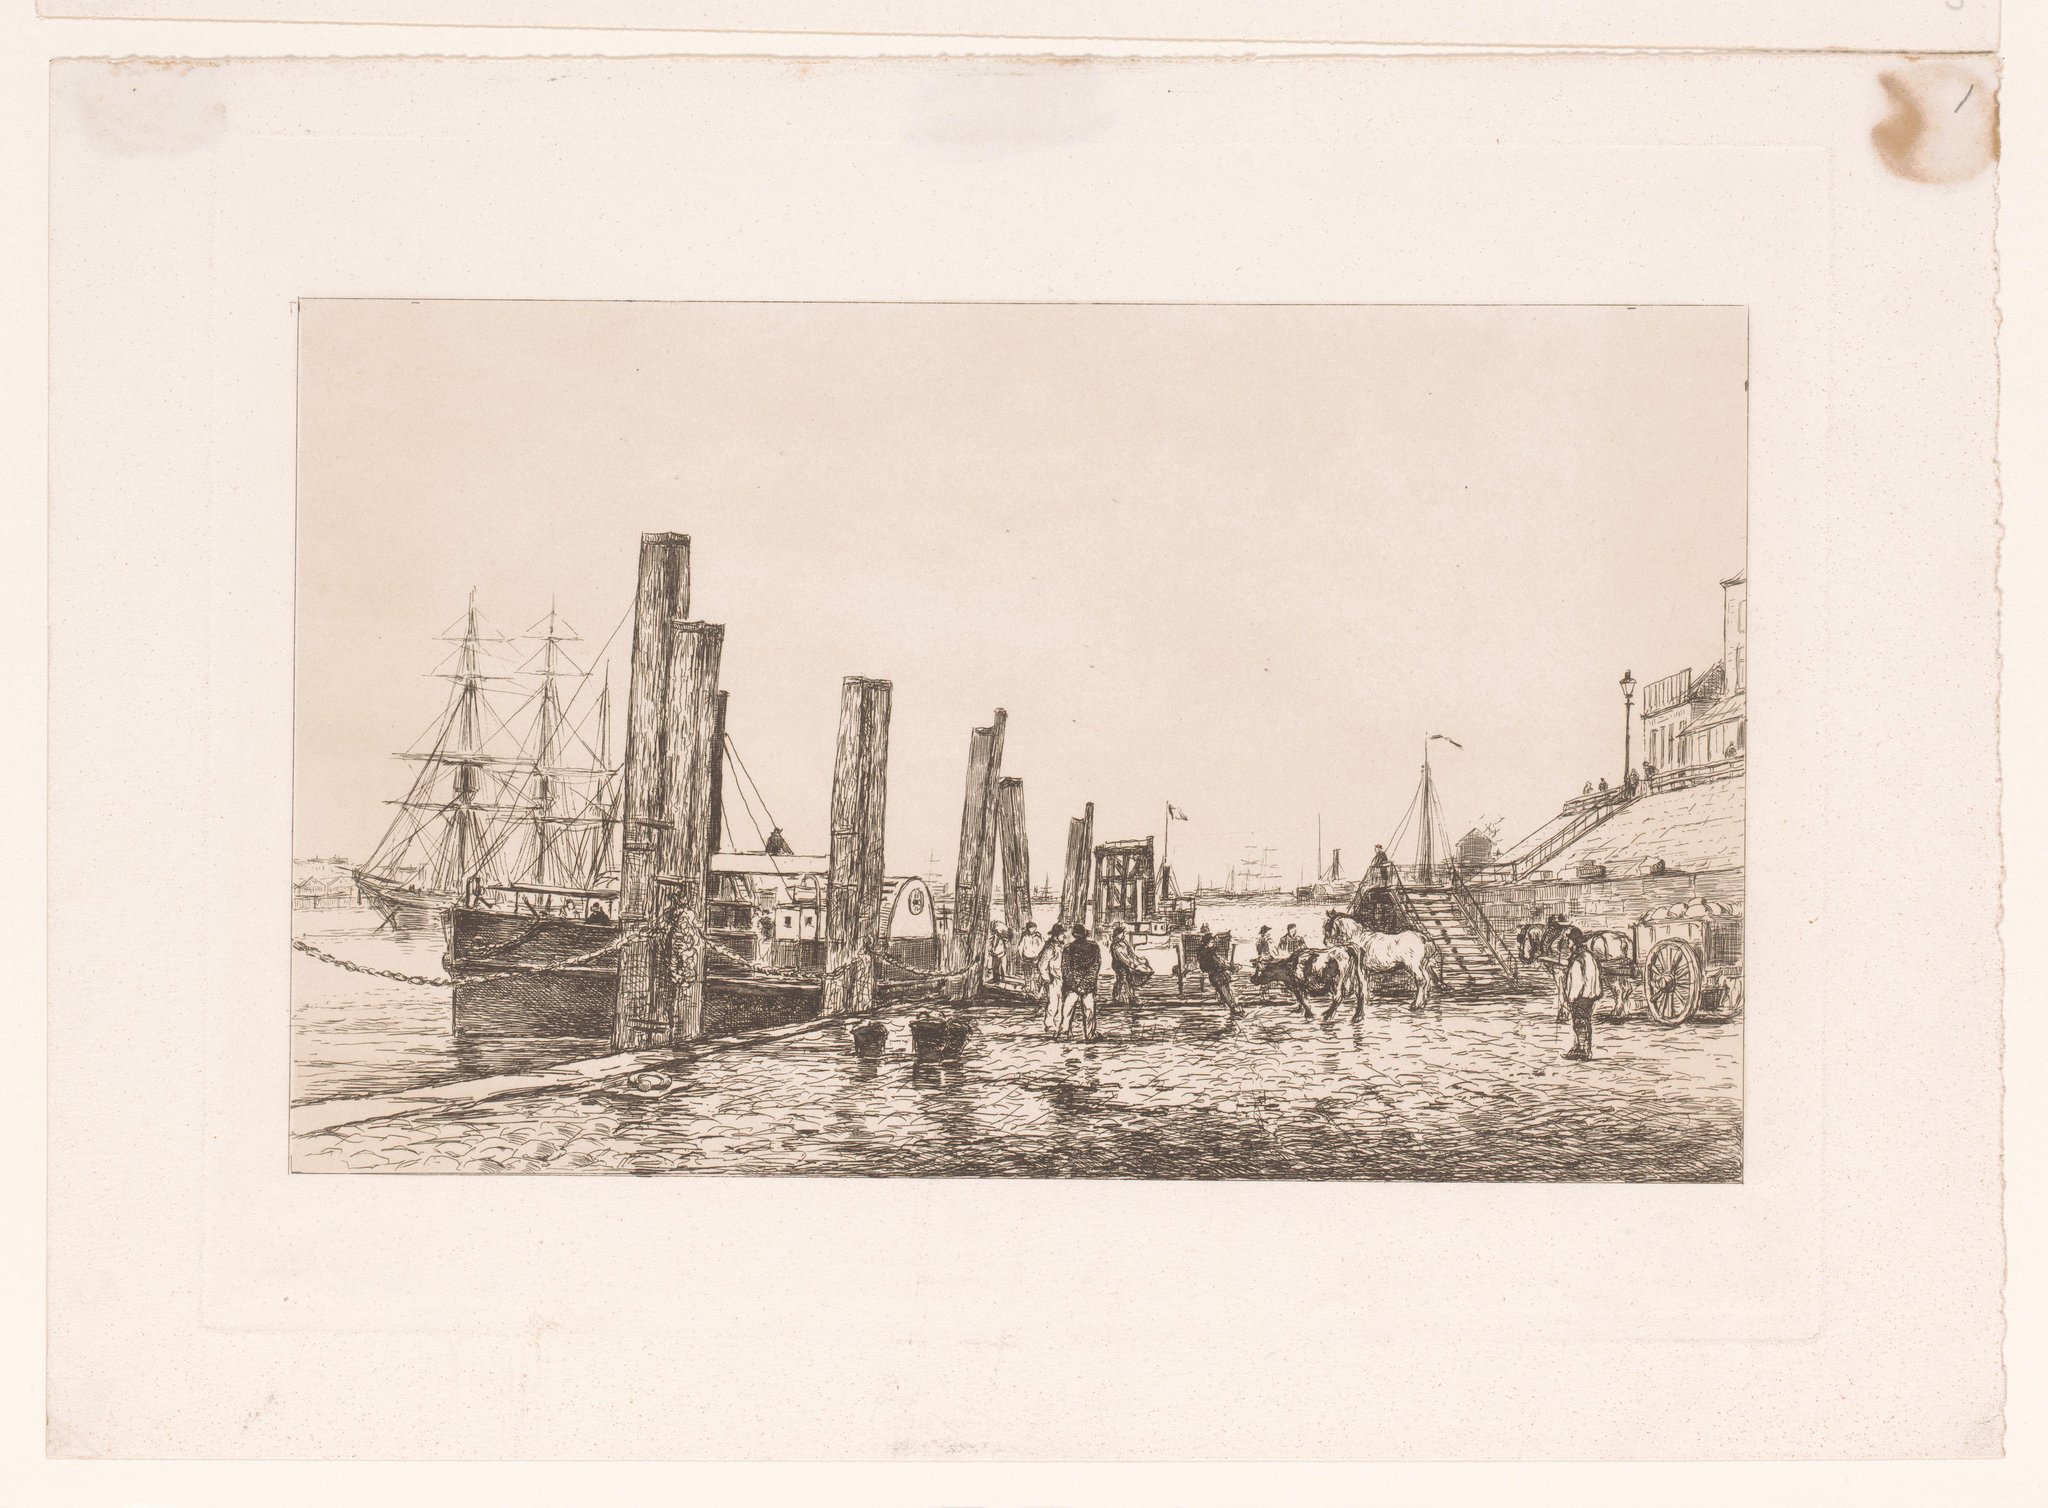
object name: print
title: Raderstoomboot aangemeerd aan een kade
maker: henri seghers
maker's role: draughtsman, painter, print maker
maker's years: 1848-1919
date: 1858-1913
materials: paper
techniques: drypoint, etching, intaglio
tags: pier, quay, wharf, paddle-wheel boat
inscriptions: collector's mark: Lugt 2228